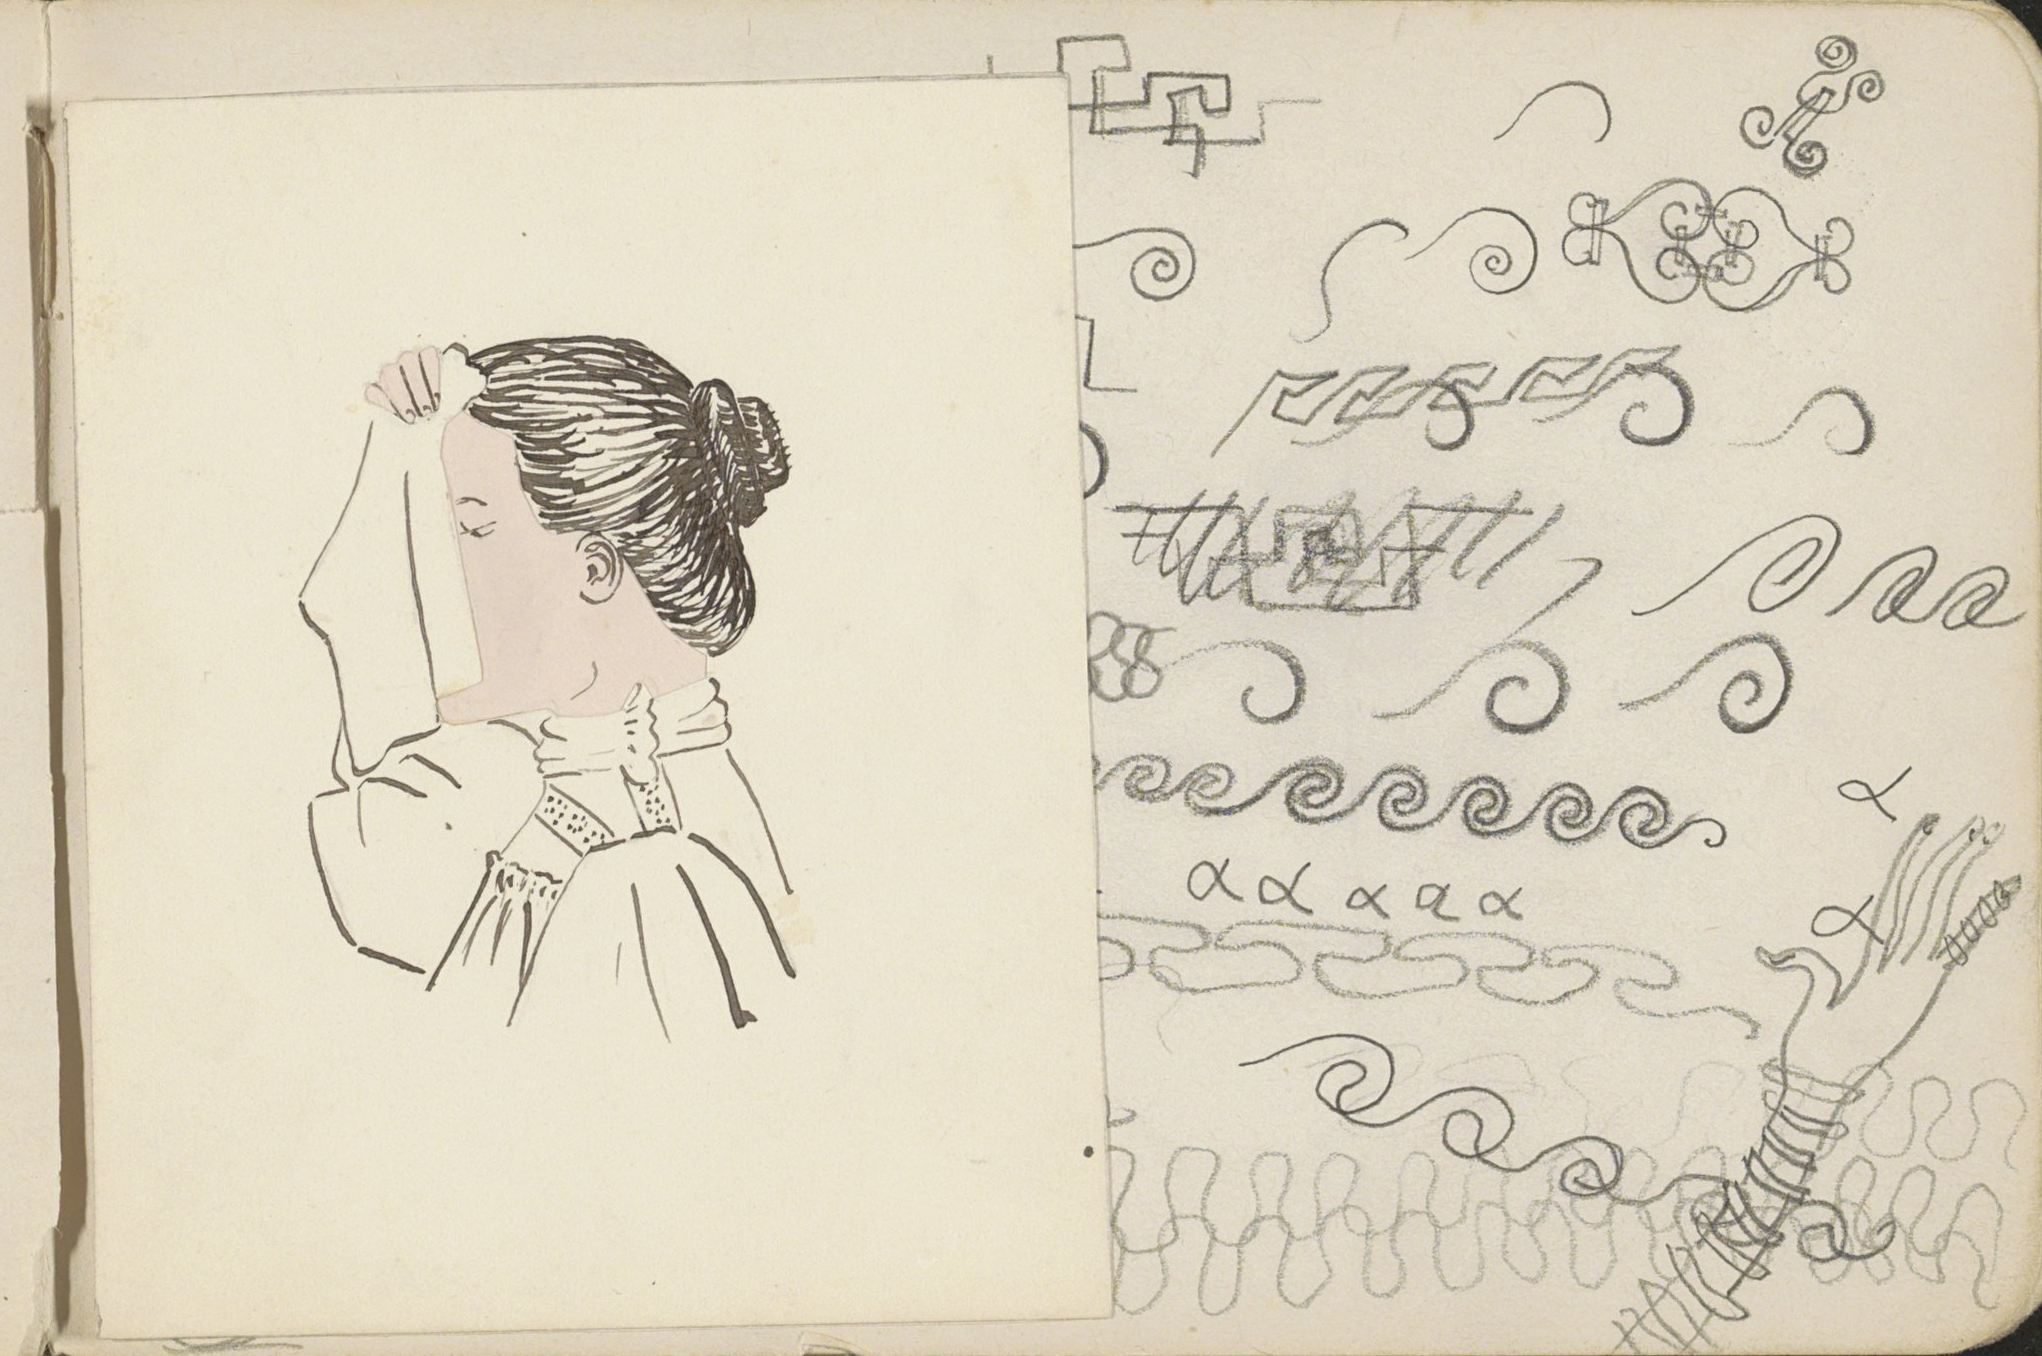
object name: sketchbook leaf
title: Kop van een vrouw met een zakdoek voor haar gezicht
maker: julie de graag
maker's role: draughtsman, print maker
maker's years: 1877-1924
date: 1894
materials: ink, paper, pencil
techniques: pen, snipping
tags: head (human), adult woman, handkerchief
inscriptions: collector's mark: Lugt 2228a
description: Losse tekening tussen pagina 34 en 35 van een schetsboek met 35 bladen.